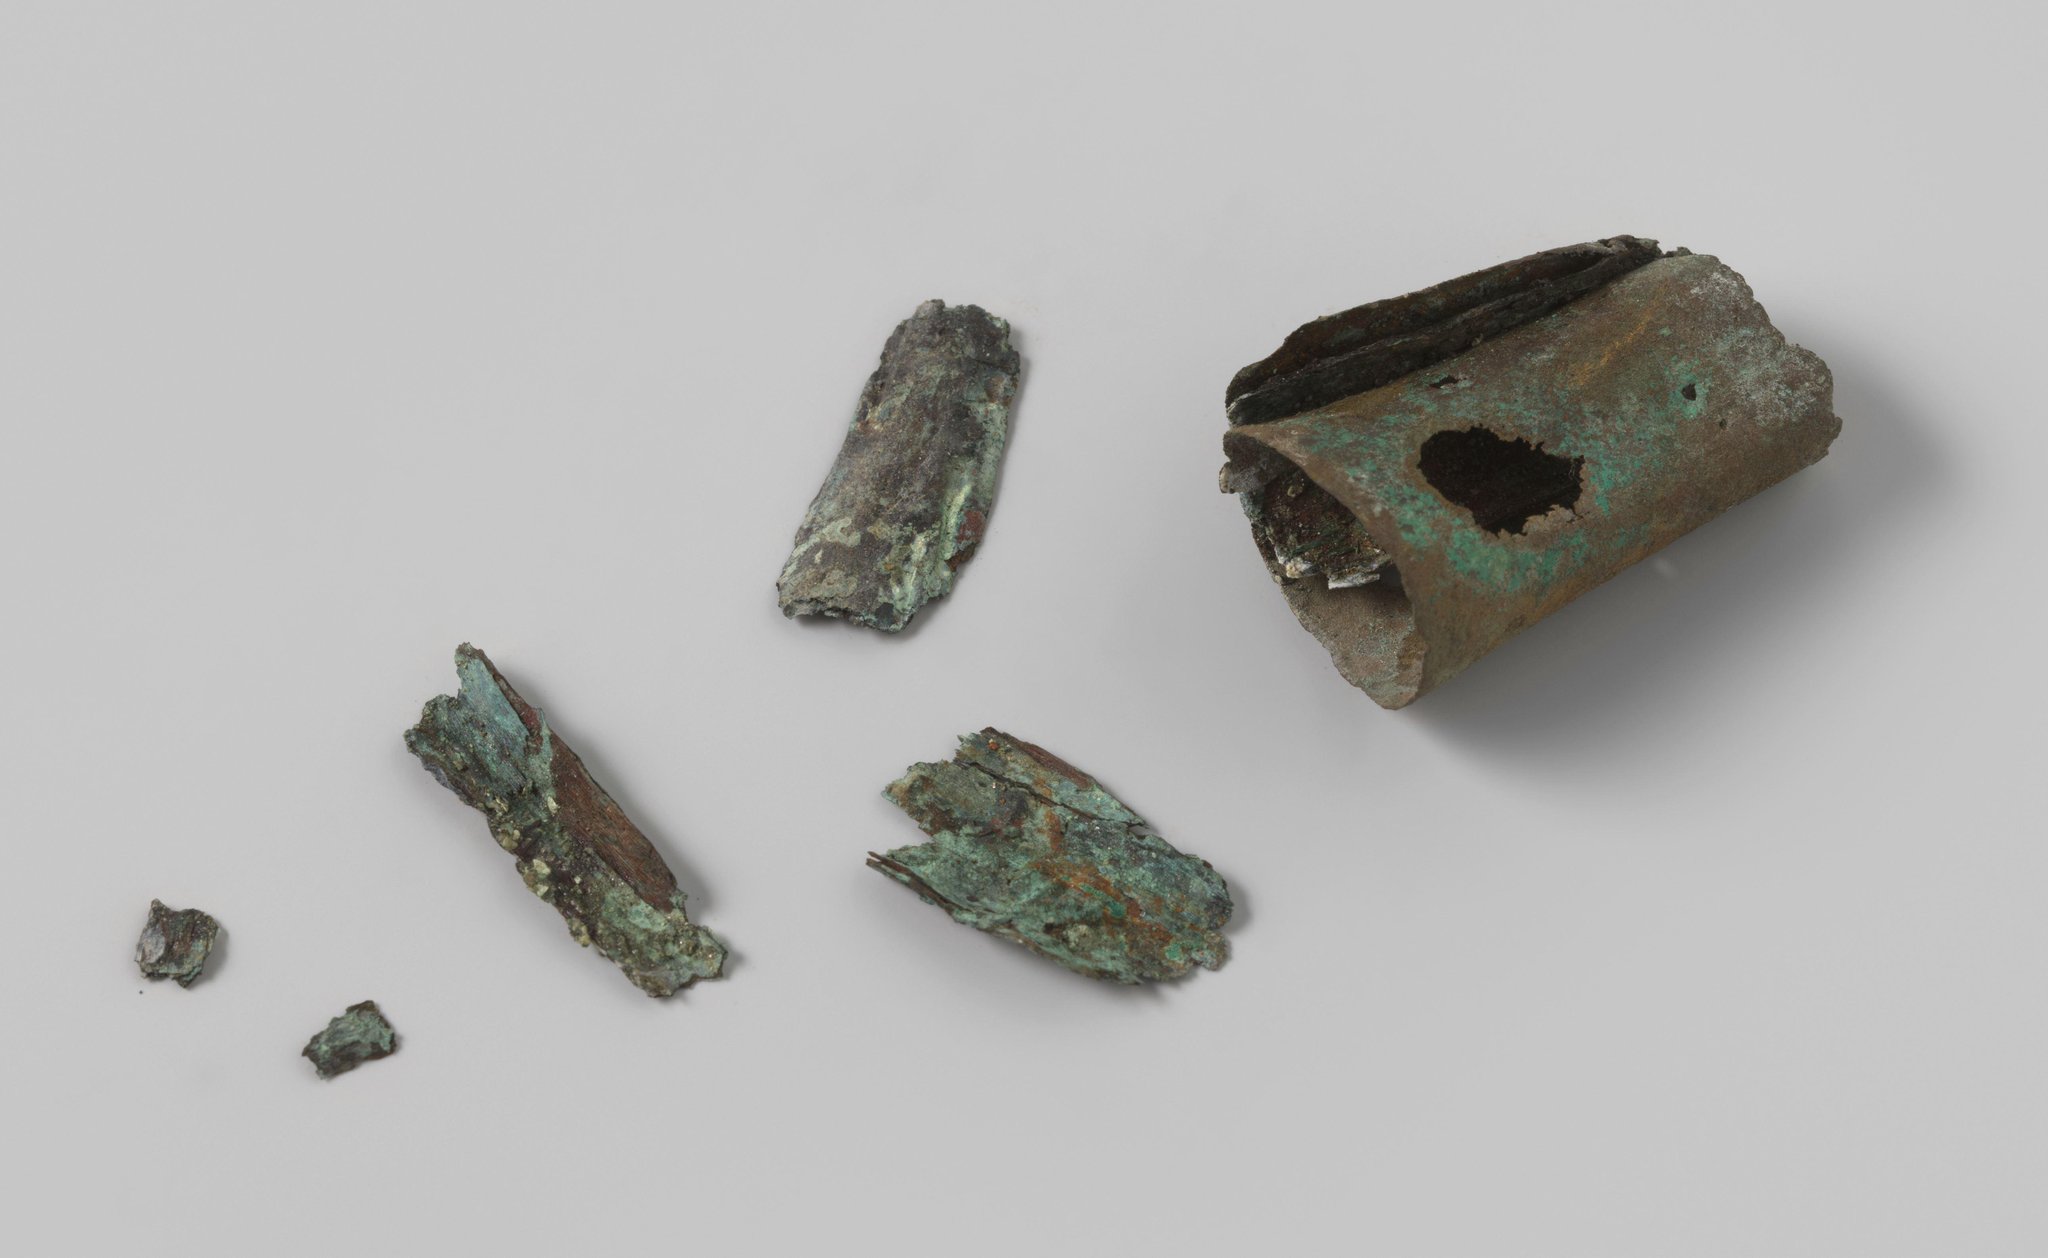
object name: powder horn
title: Fragmenten van een kruithoorn uit het wrak van de Oost-Indiëvaarder Hollandia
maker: Anonymous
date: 1700-1743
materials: copper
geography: netherlands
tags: verenigde oostindische compagnie, hollandia (schip), annet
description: Powderhorn, nozzle; fragm, id. NG 1979-52/53H636, squashed, eroded.